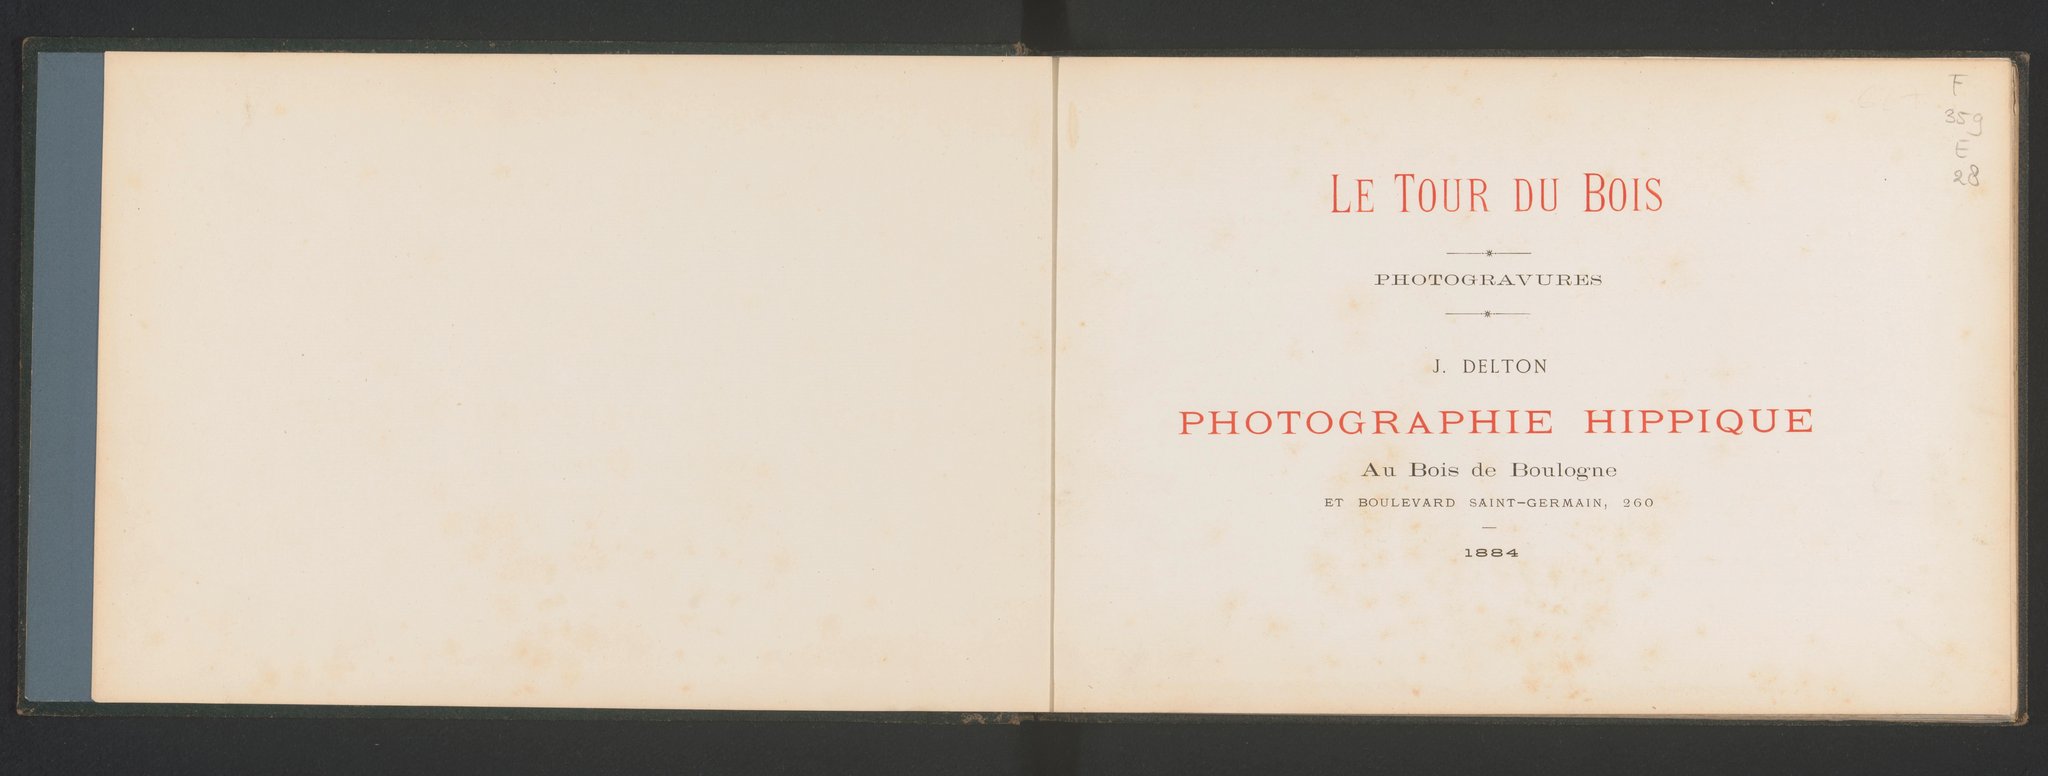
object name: book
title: Le tour du bois photogravures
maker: jean delton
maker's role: fotograaf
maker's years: 1850-1901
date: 1884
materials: cardboard, linen, paper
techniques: photoaquatint